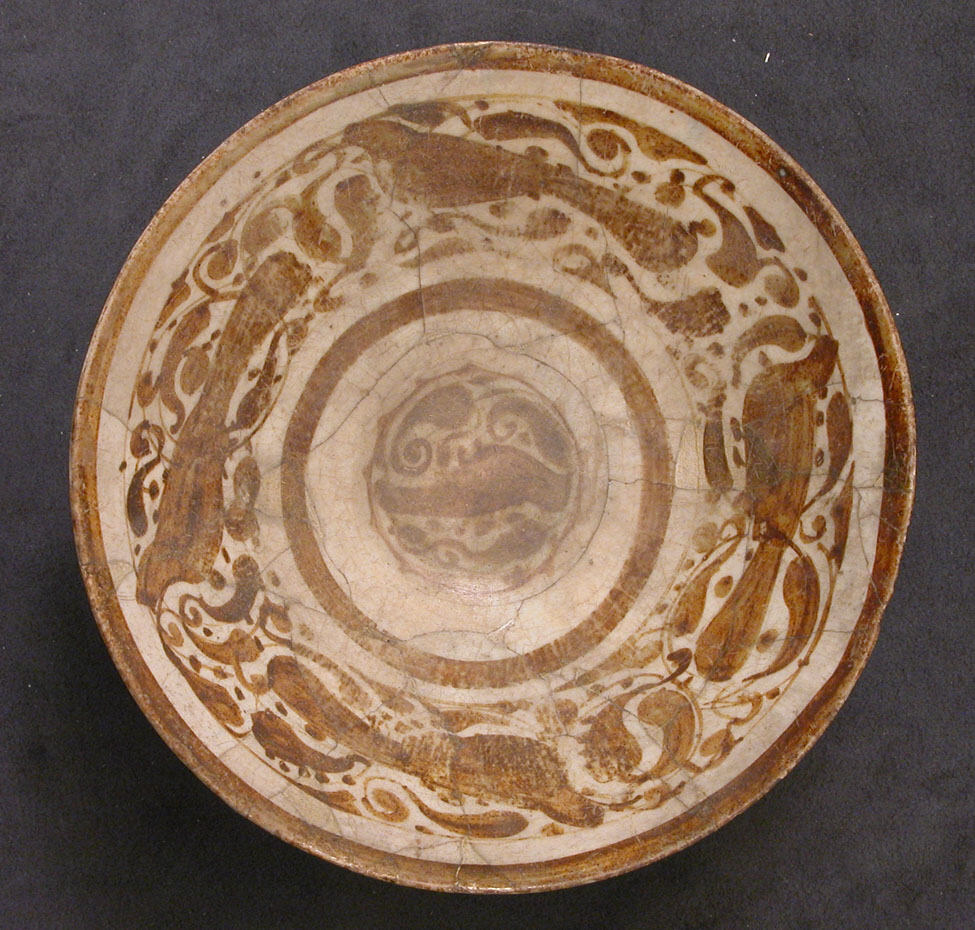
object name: bowl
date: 1101-1300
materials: glaze, stonepaste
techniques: luster painting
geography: iran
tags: birds